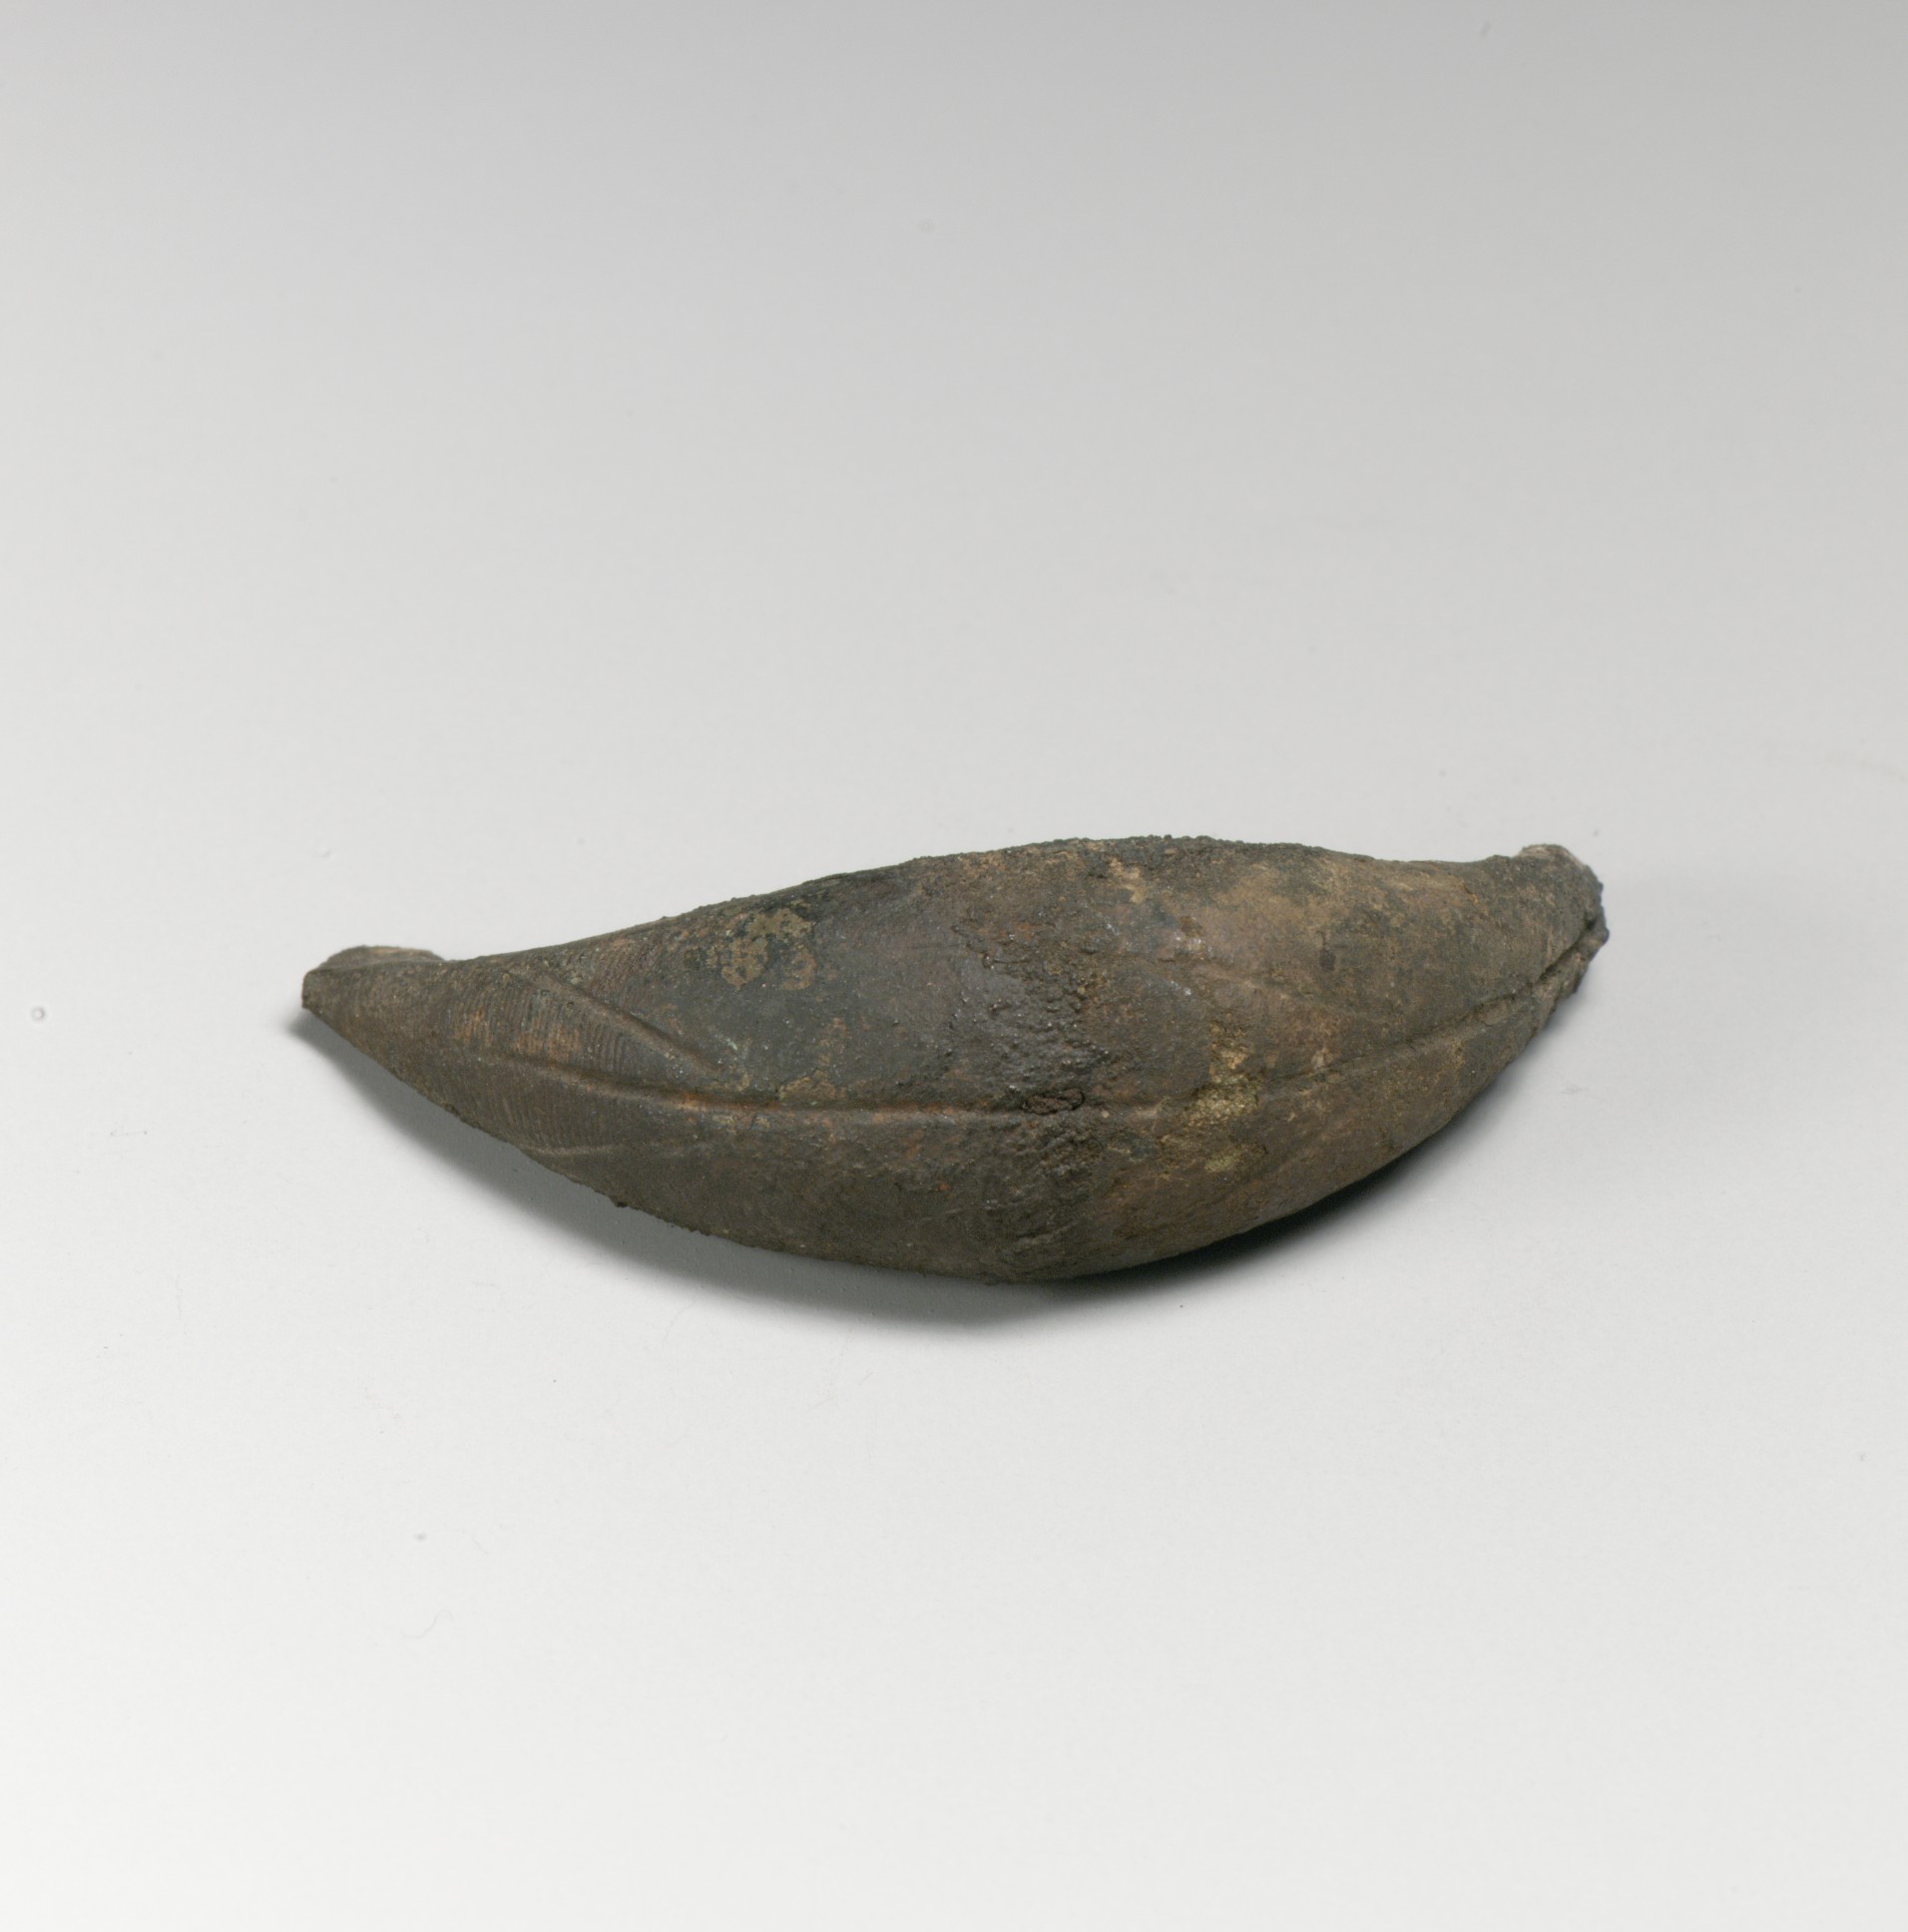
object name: fibula, boat shaped type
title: Fibula, boat-shaped type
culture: italic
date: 900-701 BCE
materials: bronze